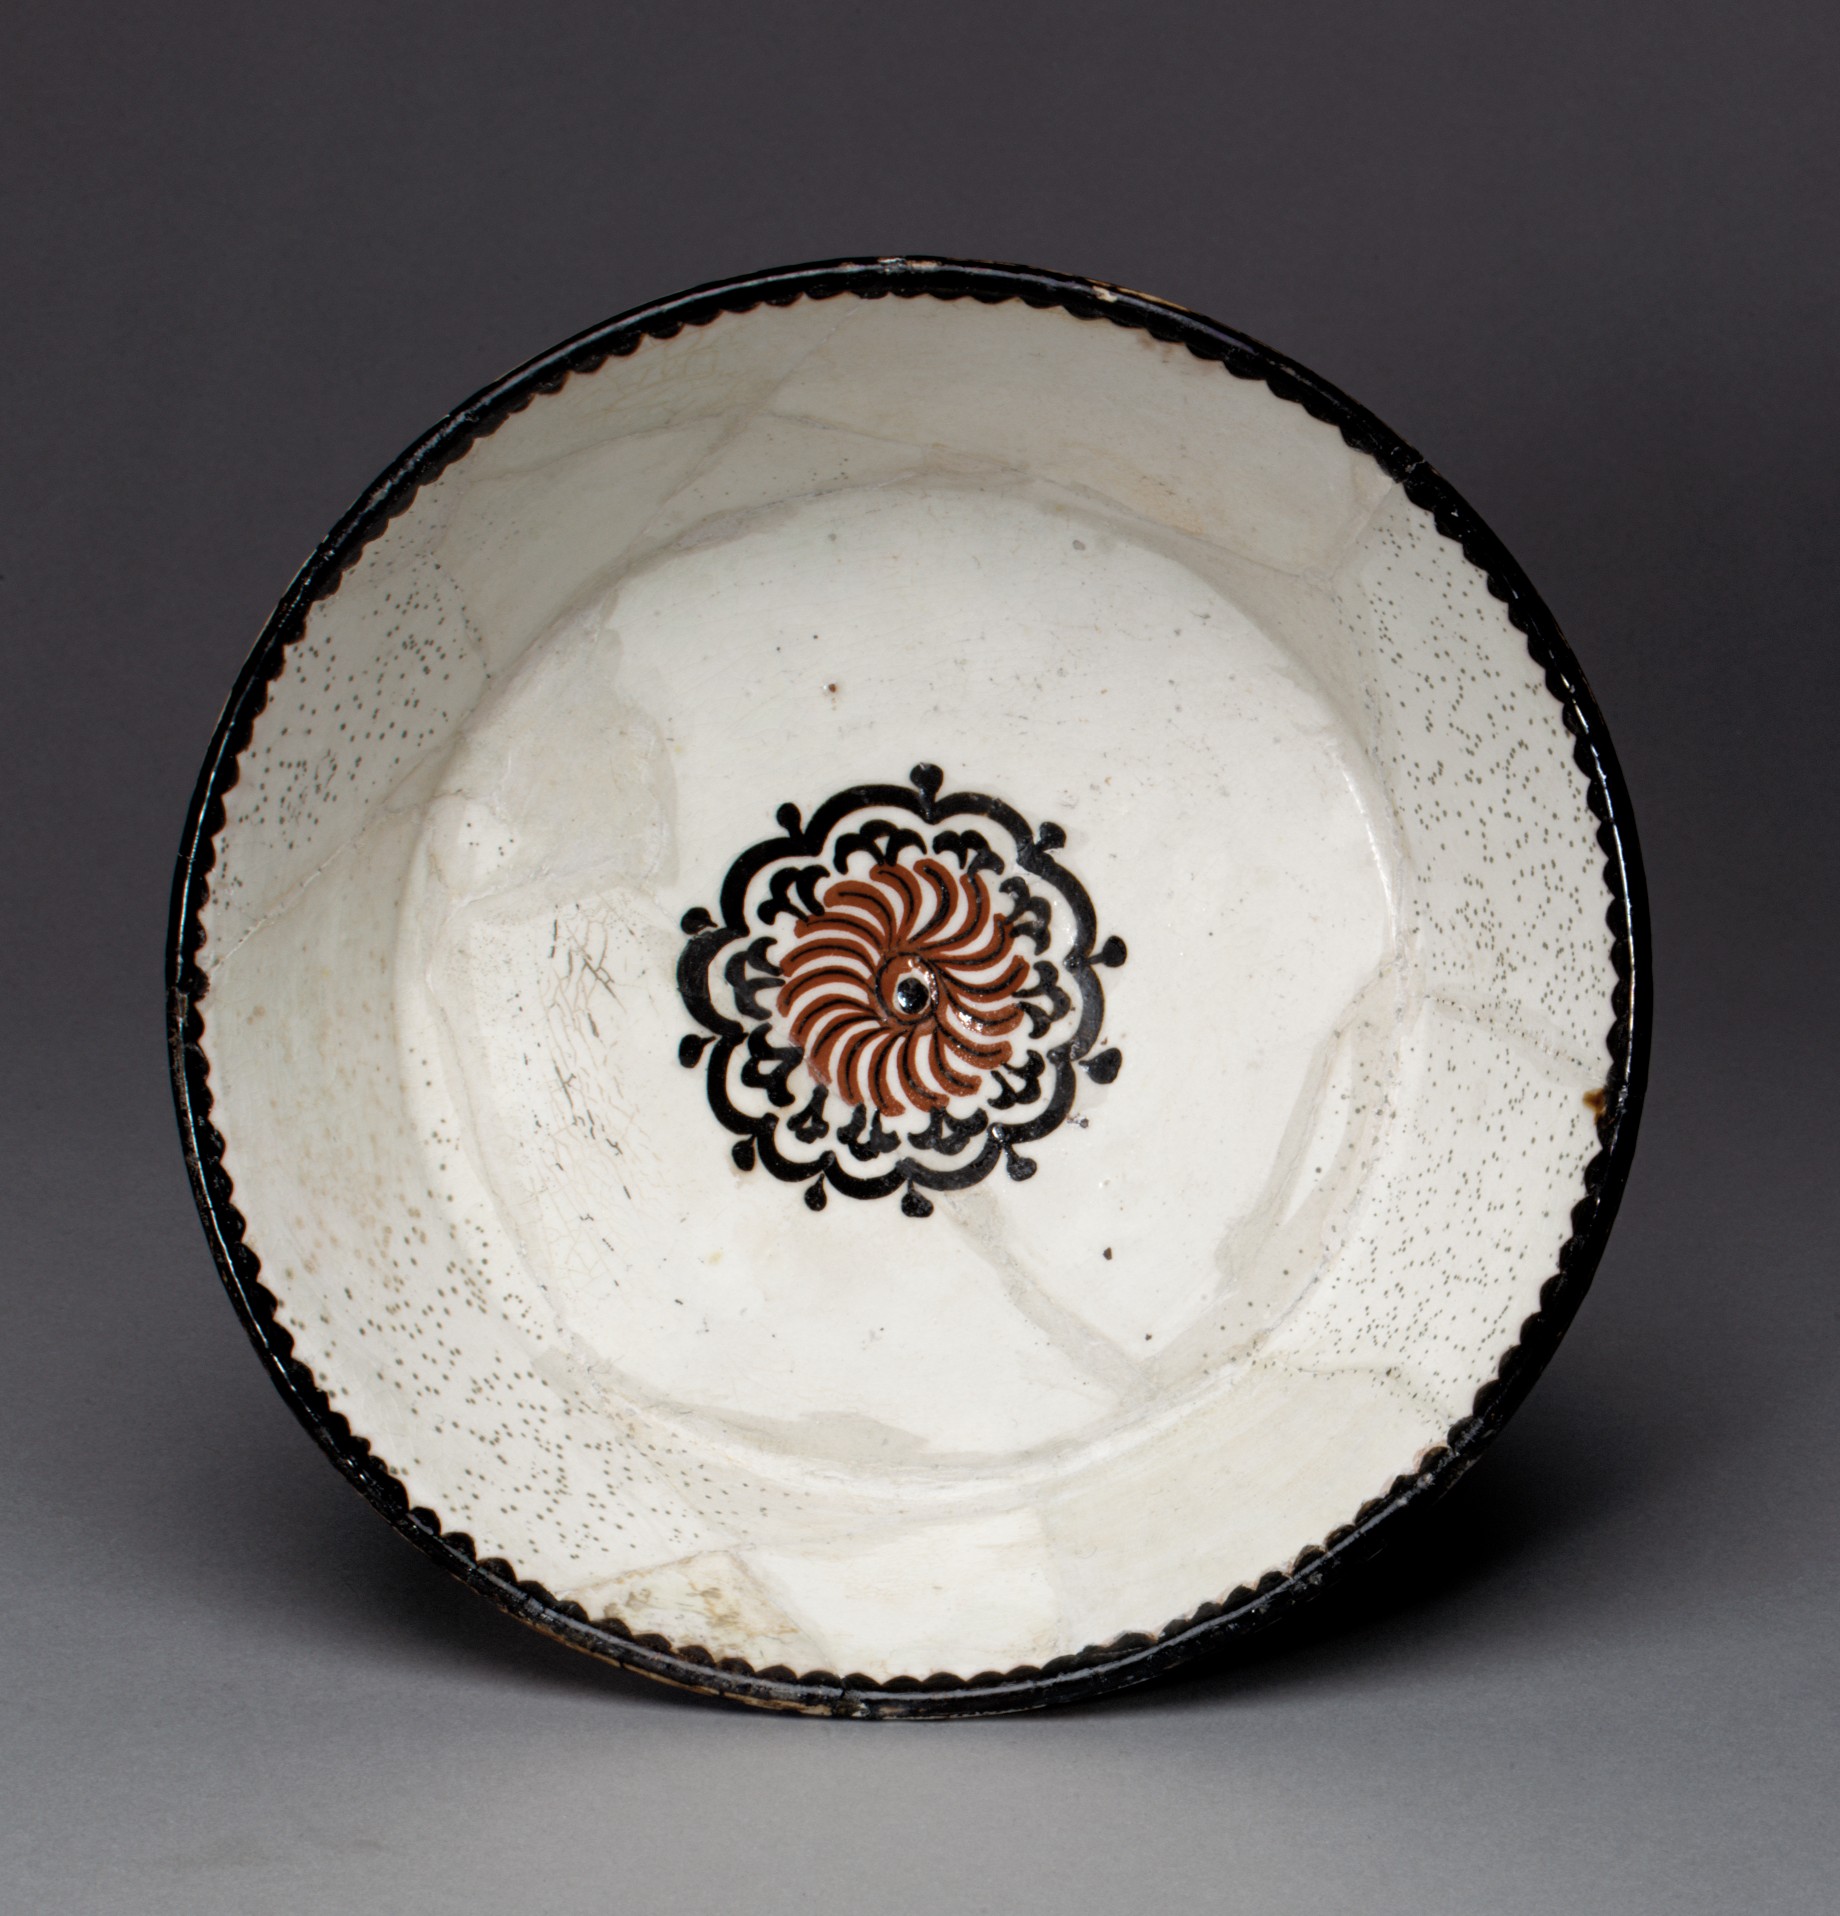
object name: bowl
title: Bowl with Rosette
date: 901-1000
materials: earthenware, glaze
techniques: polychrome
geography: uzbekistan